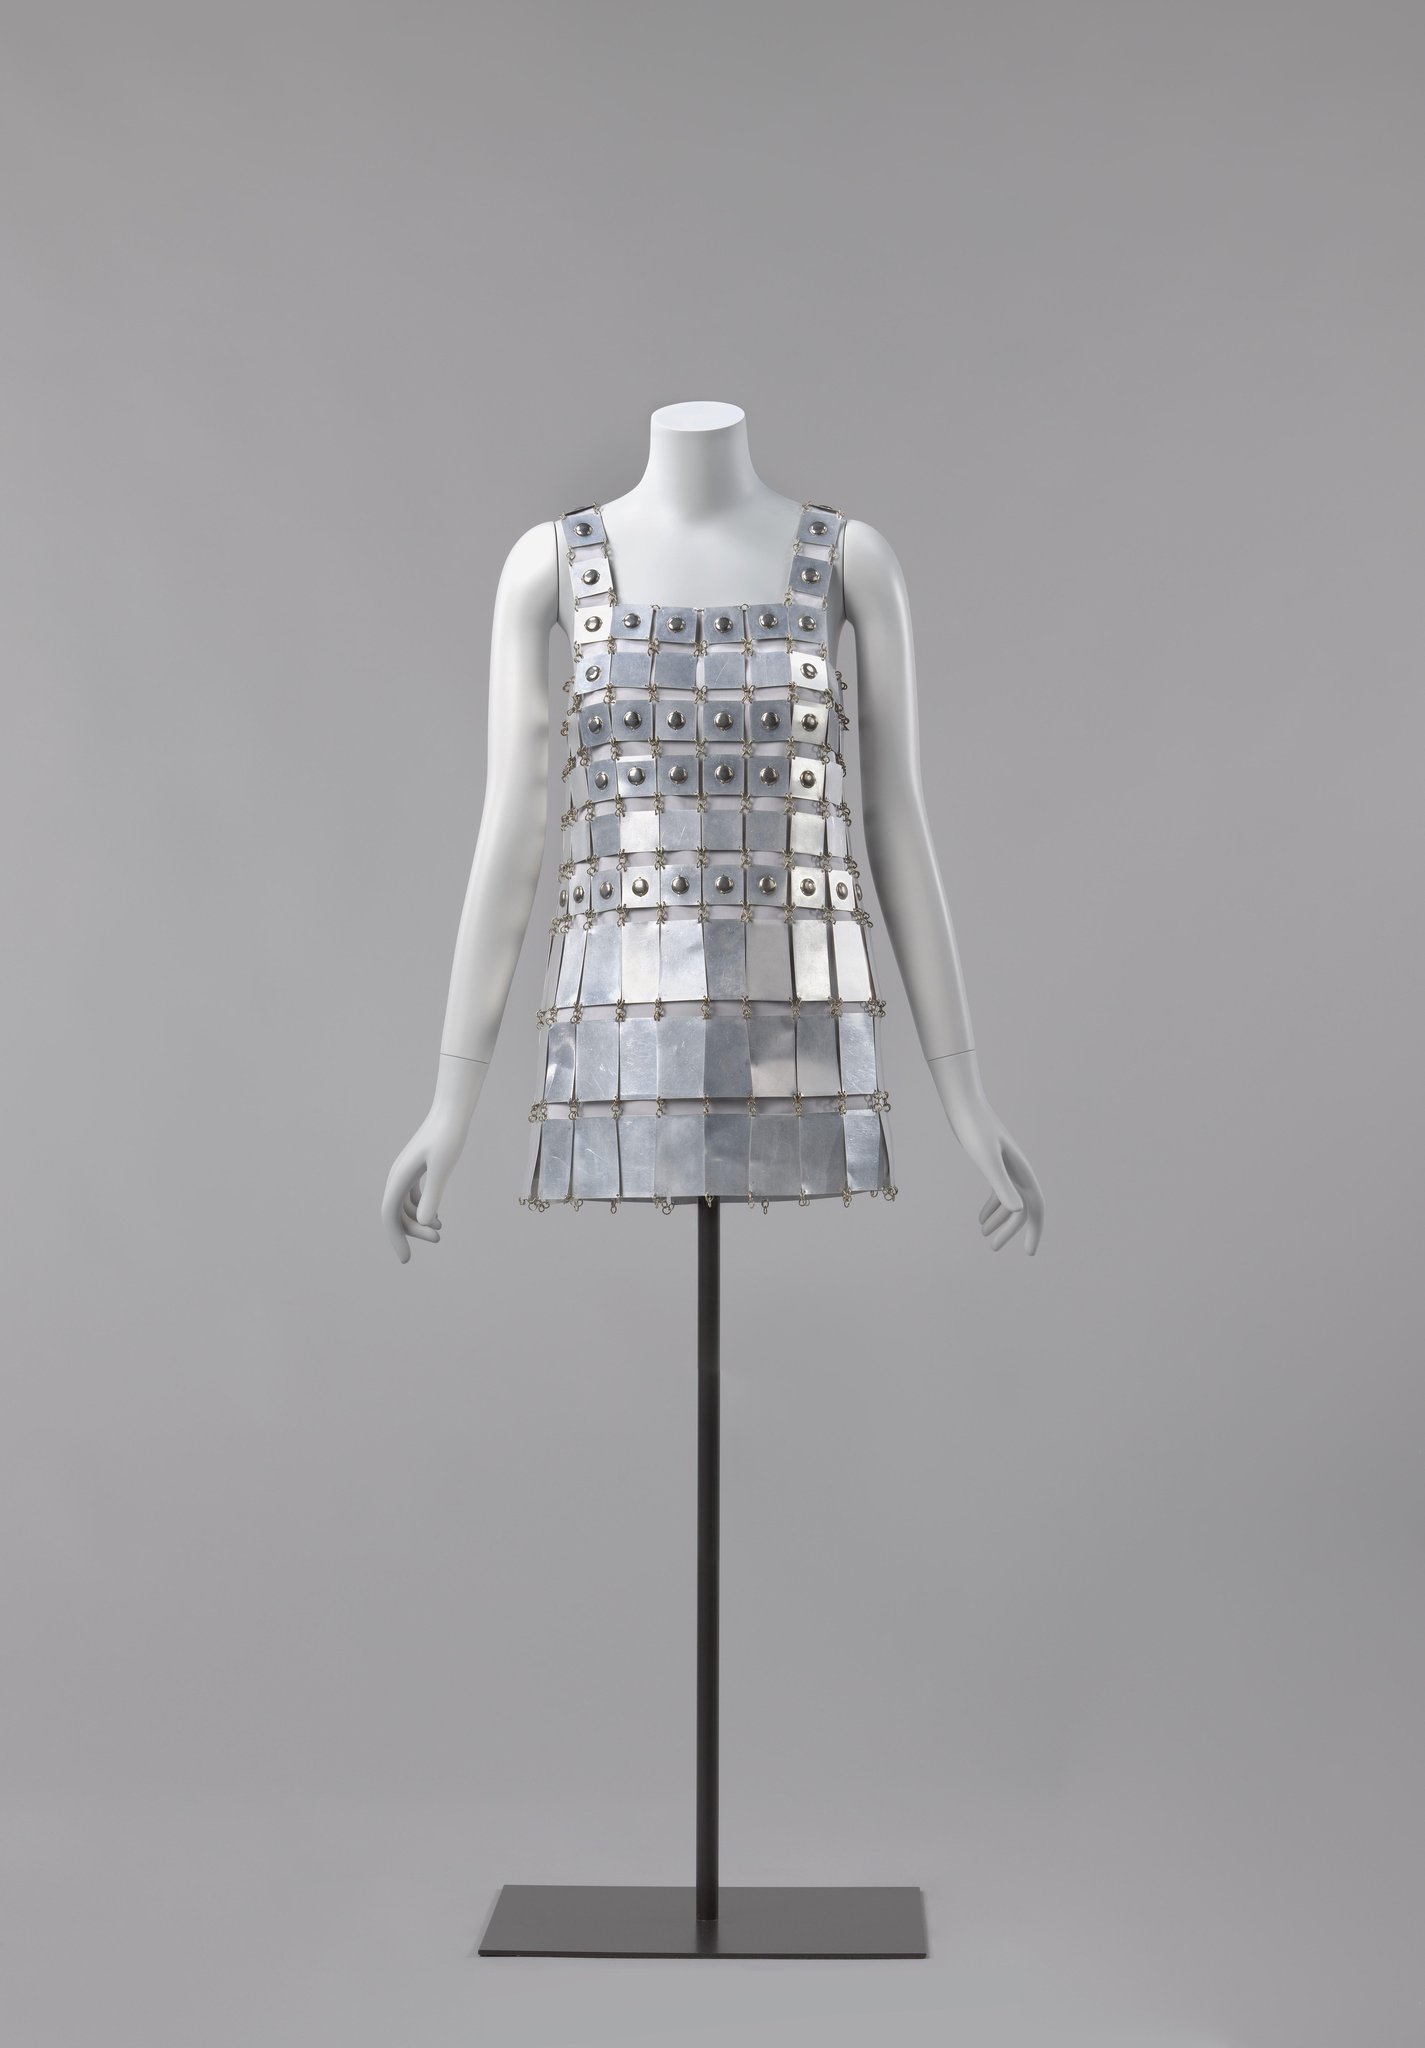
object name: robe, japon, jurk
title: Dress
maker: paco rabanne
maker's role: modeontwerper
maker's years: 1934-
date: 1967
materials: aluminum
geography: paris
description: The modern plastic and aluminum chain mail dresses that Paco Rabanne designed in the mid-1960s were a radical departure from traditional couture. By using reflective or transparent materials and repeating elements, he connected seamlessly with art movements such as Zero and Op Art, which expressed the aesthetics of the space age.